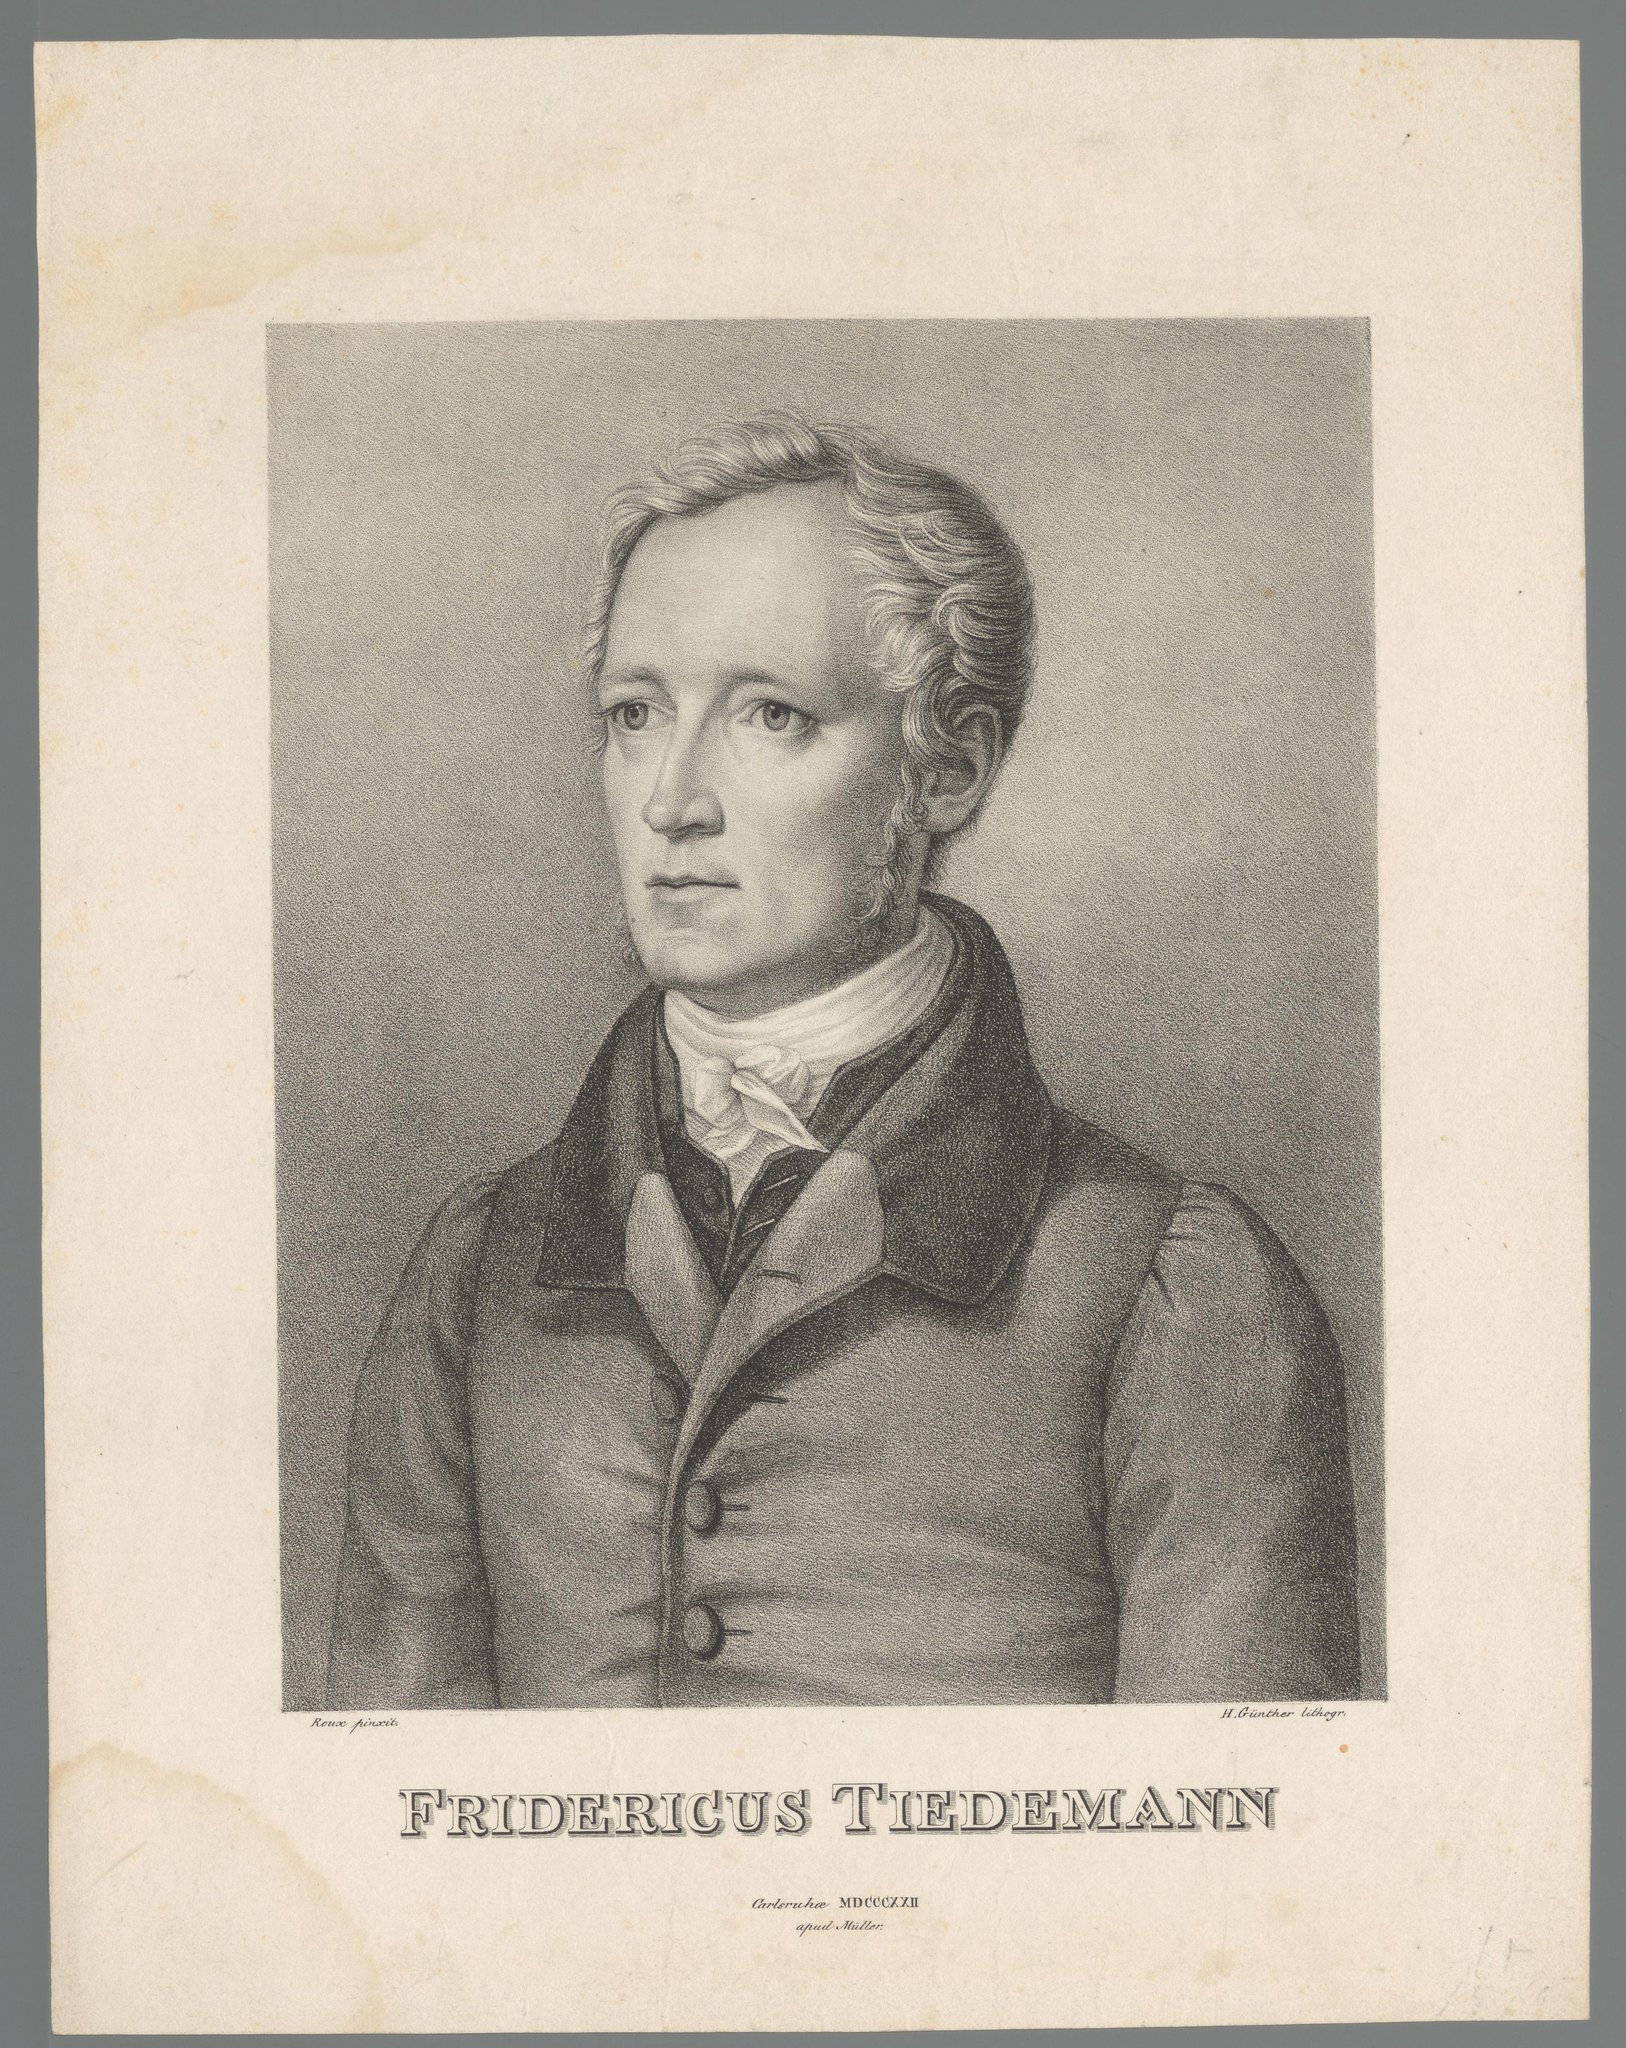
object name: print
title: Fridericus Tiedemann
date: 1822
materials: paper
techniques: lithograph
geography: karlsruhe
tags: adult man, historical persons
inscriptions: collector's mark: Lugt 2228